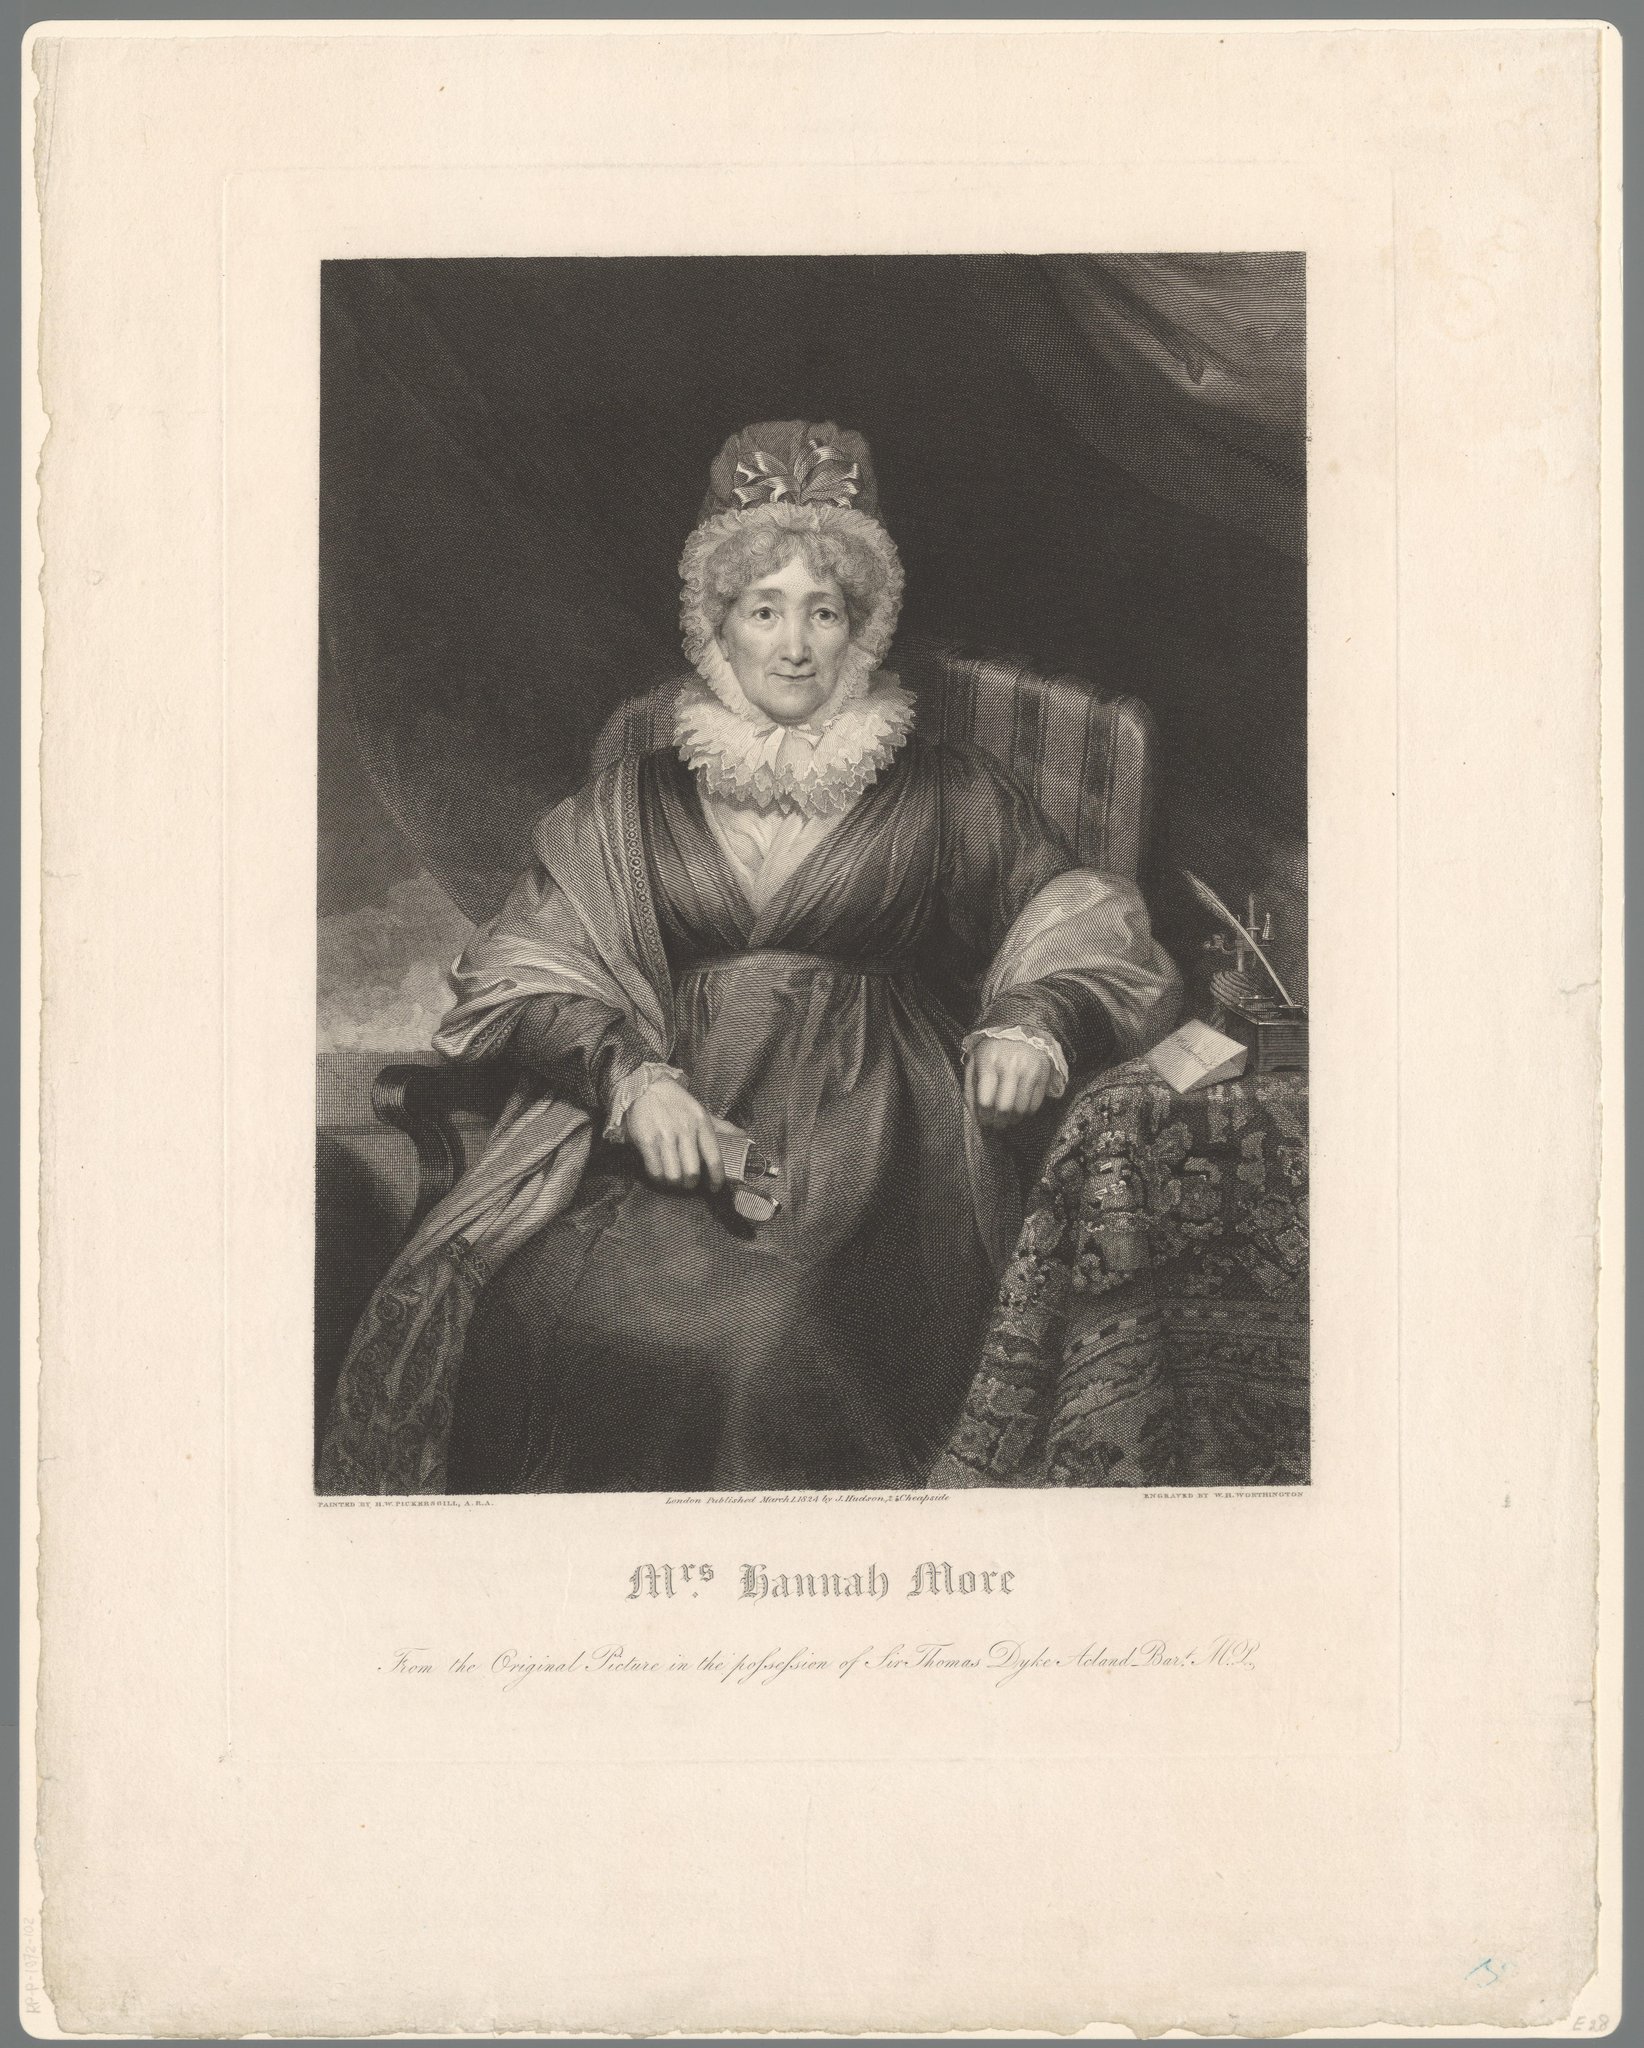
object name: print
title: Portret van Hannah More op 77-jarige leeftijd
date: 1824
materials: paper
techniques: engraving, etching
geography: london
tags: historical persons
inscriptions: collector's mark: Lugt 2760, collector's mark: Lugt 2228